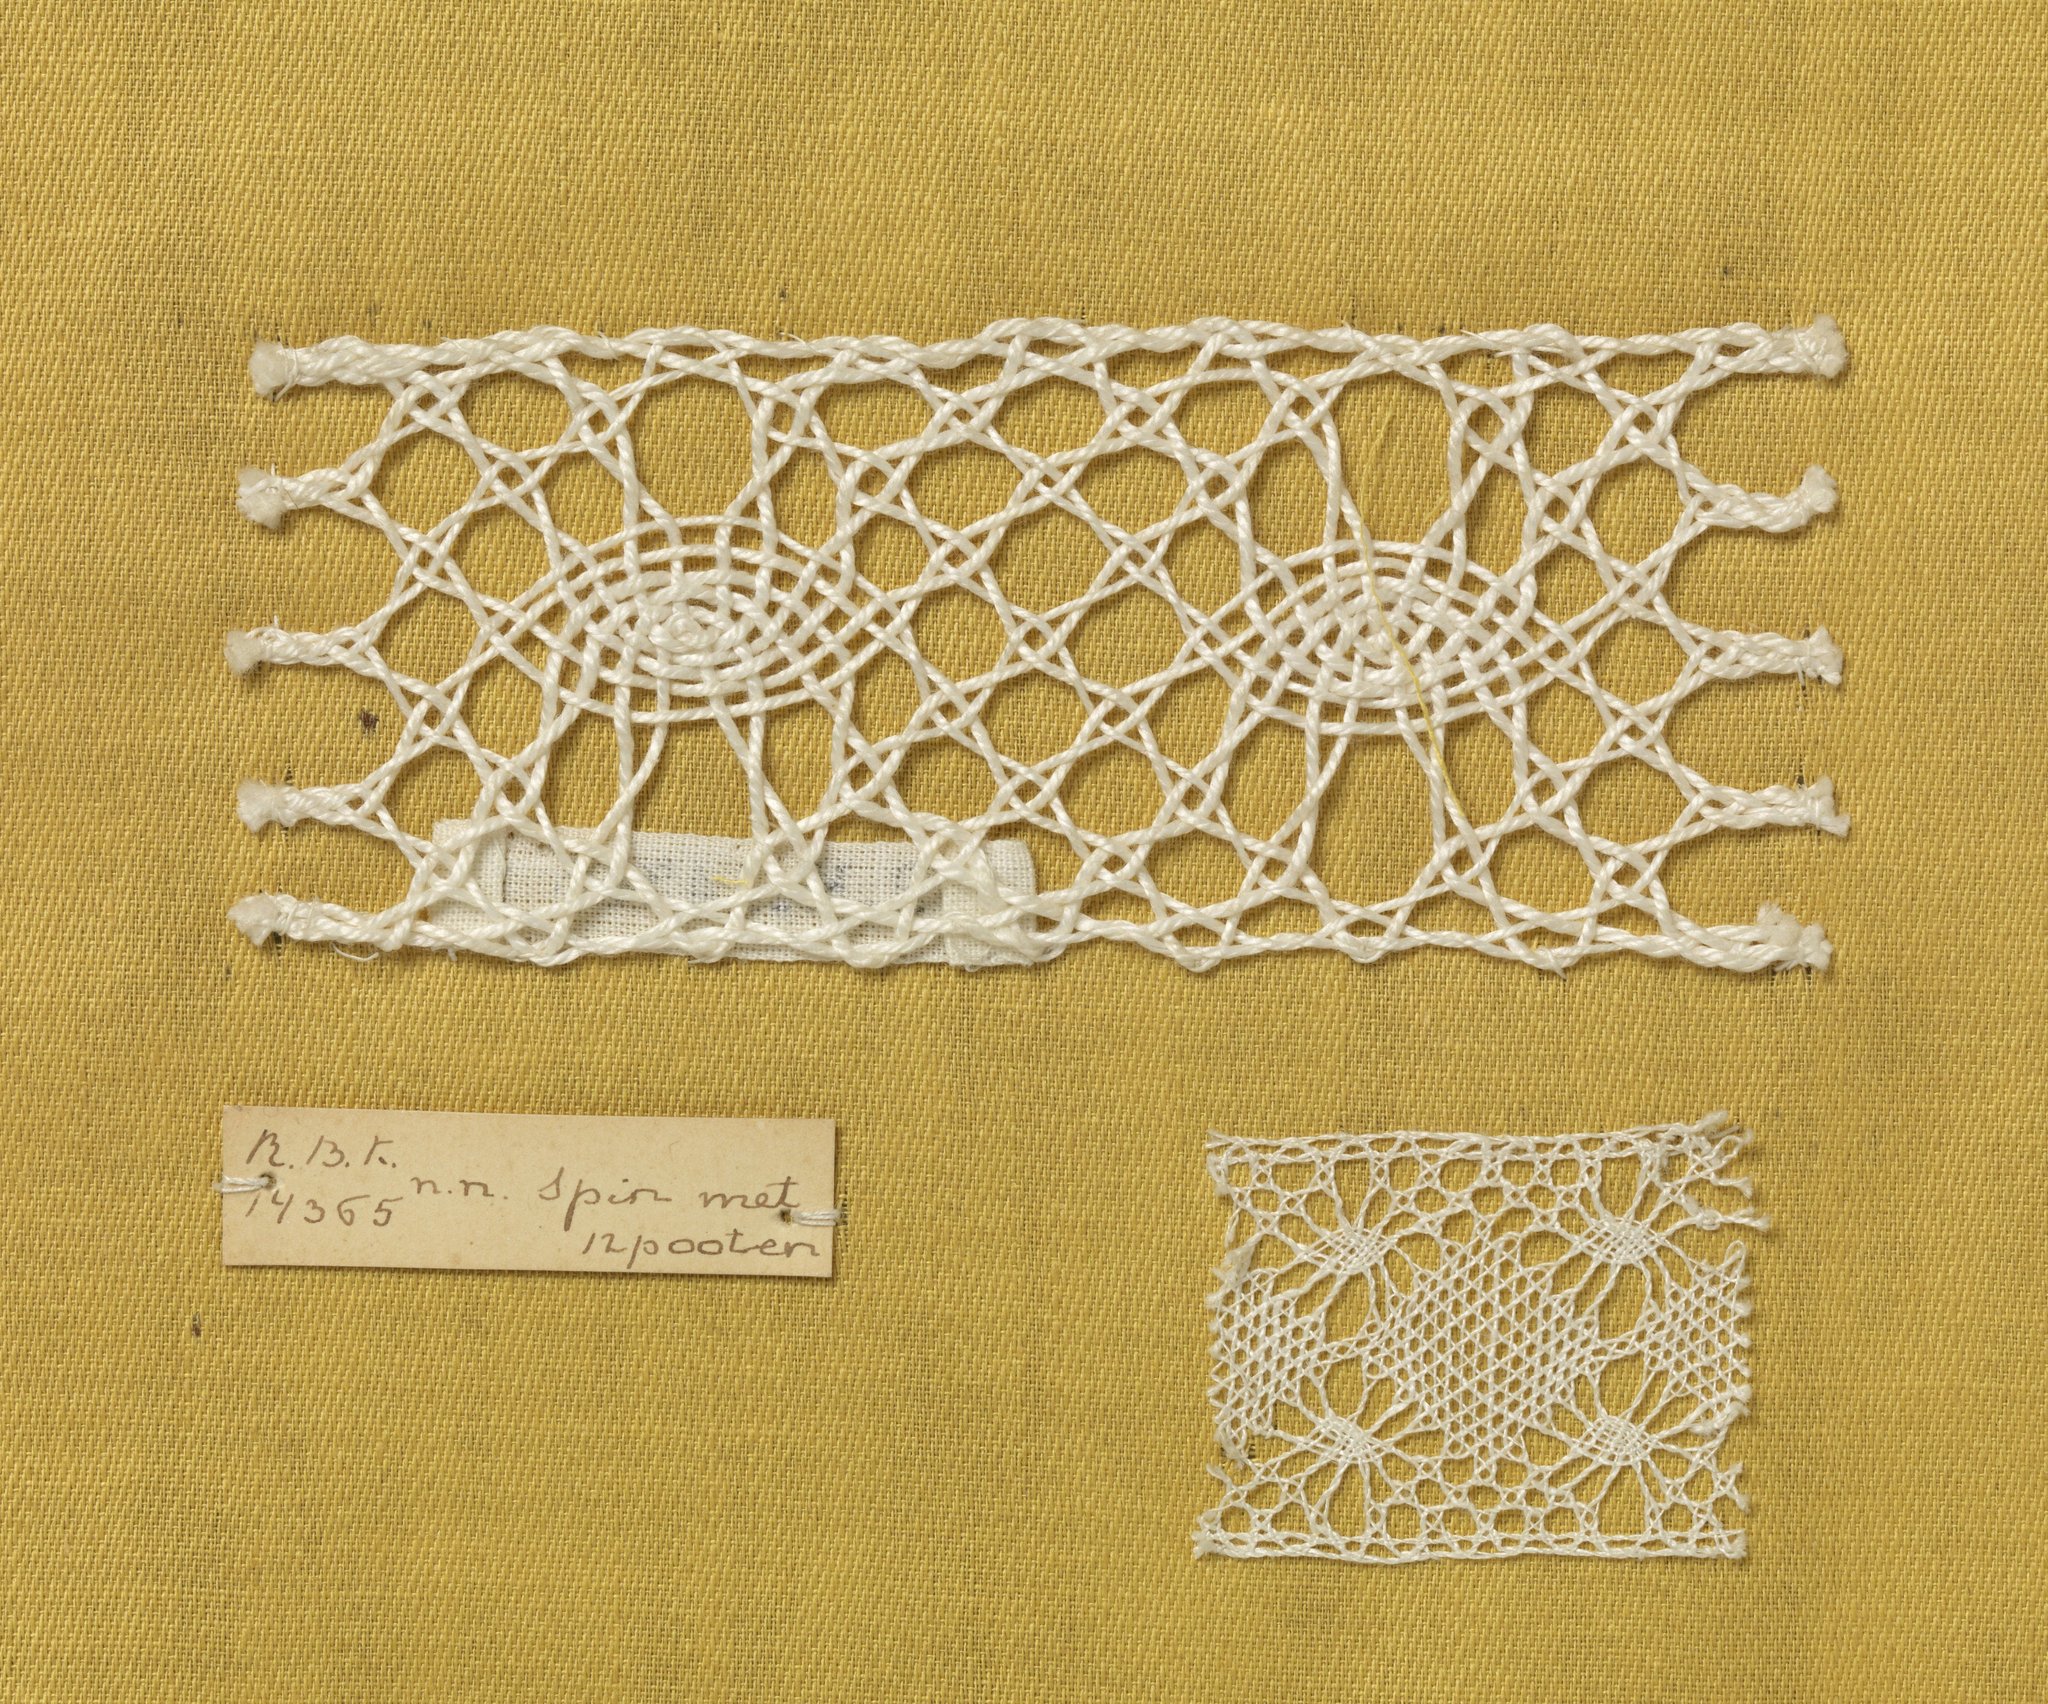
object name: sample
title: Staal kloskant met grove draad als voorbeeld van een spin met twaalf poten met daarbij een fragment stropkant waarin deze techniek is toegepast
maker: Anonymous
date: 1900-1930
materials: cotton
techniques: lace, spider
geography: western europe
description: Staal naturelkleurige kloskant met grove draad als voorbeeld van een spin met twaalf poten (het spitsovale motief) met daarbij een fragment stropkant waarin deze techniek is toegepast. In beide voorbeelden is een stroptraliegrond gebruikt en in het fragment staan de spinnen rond een ruit in netslag. De datering betreft het staal.